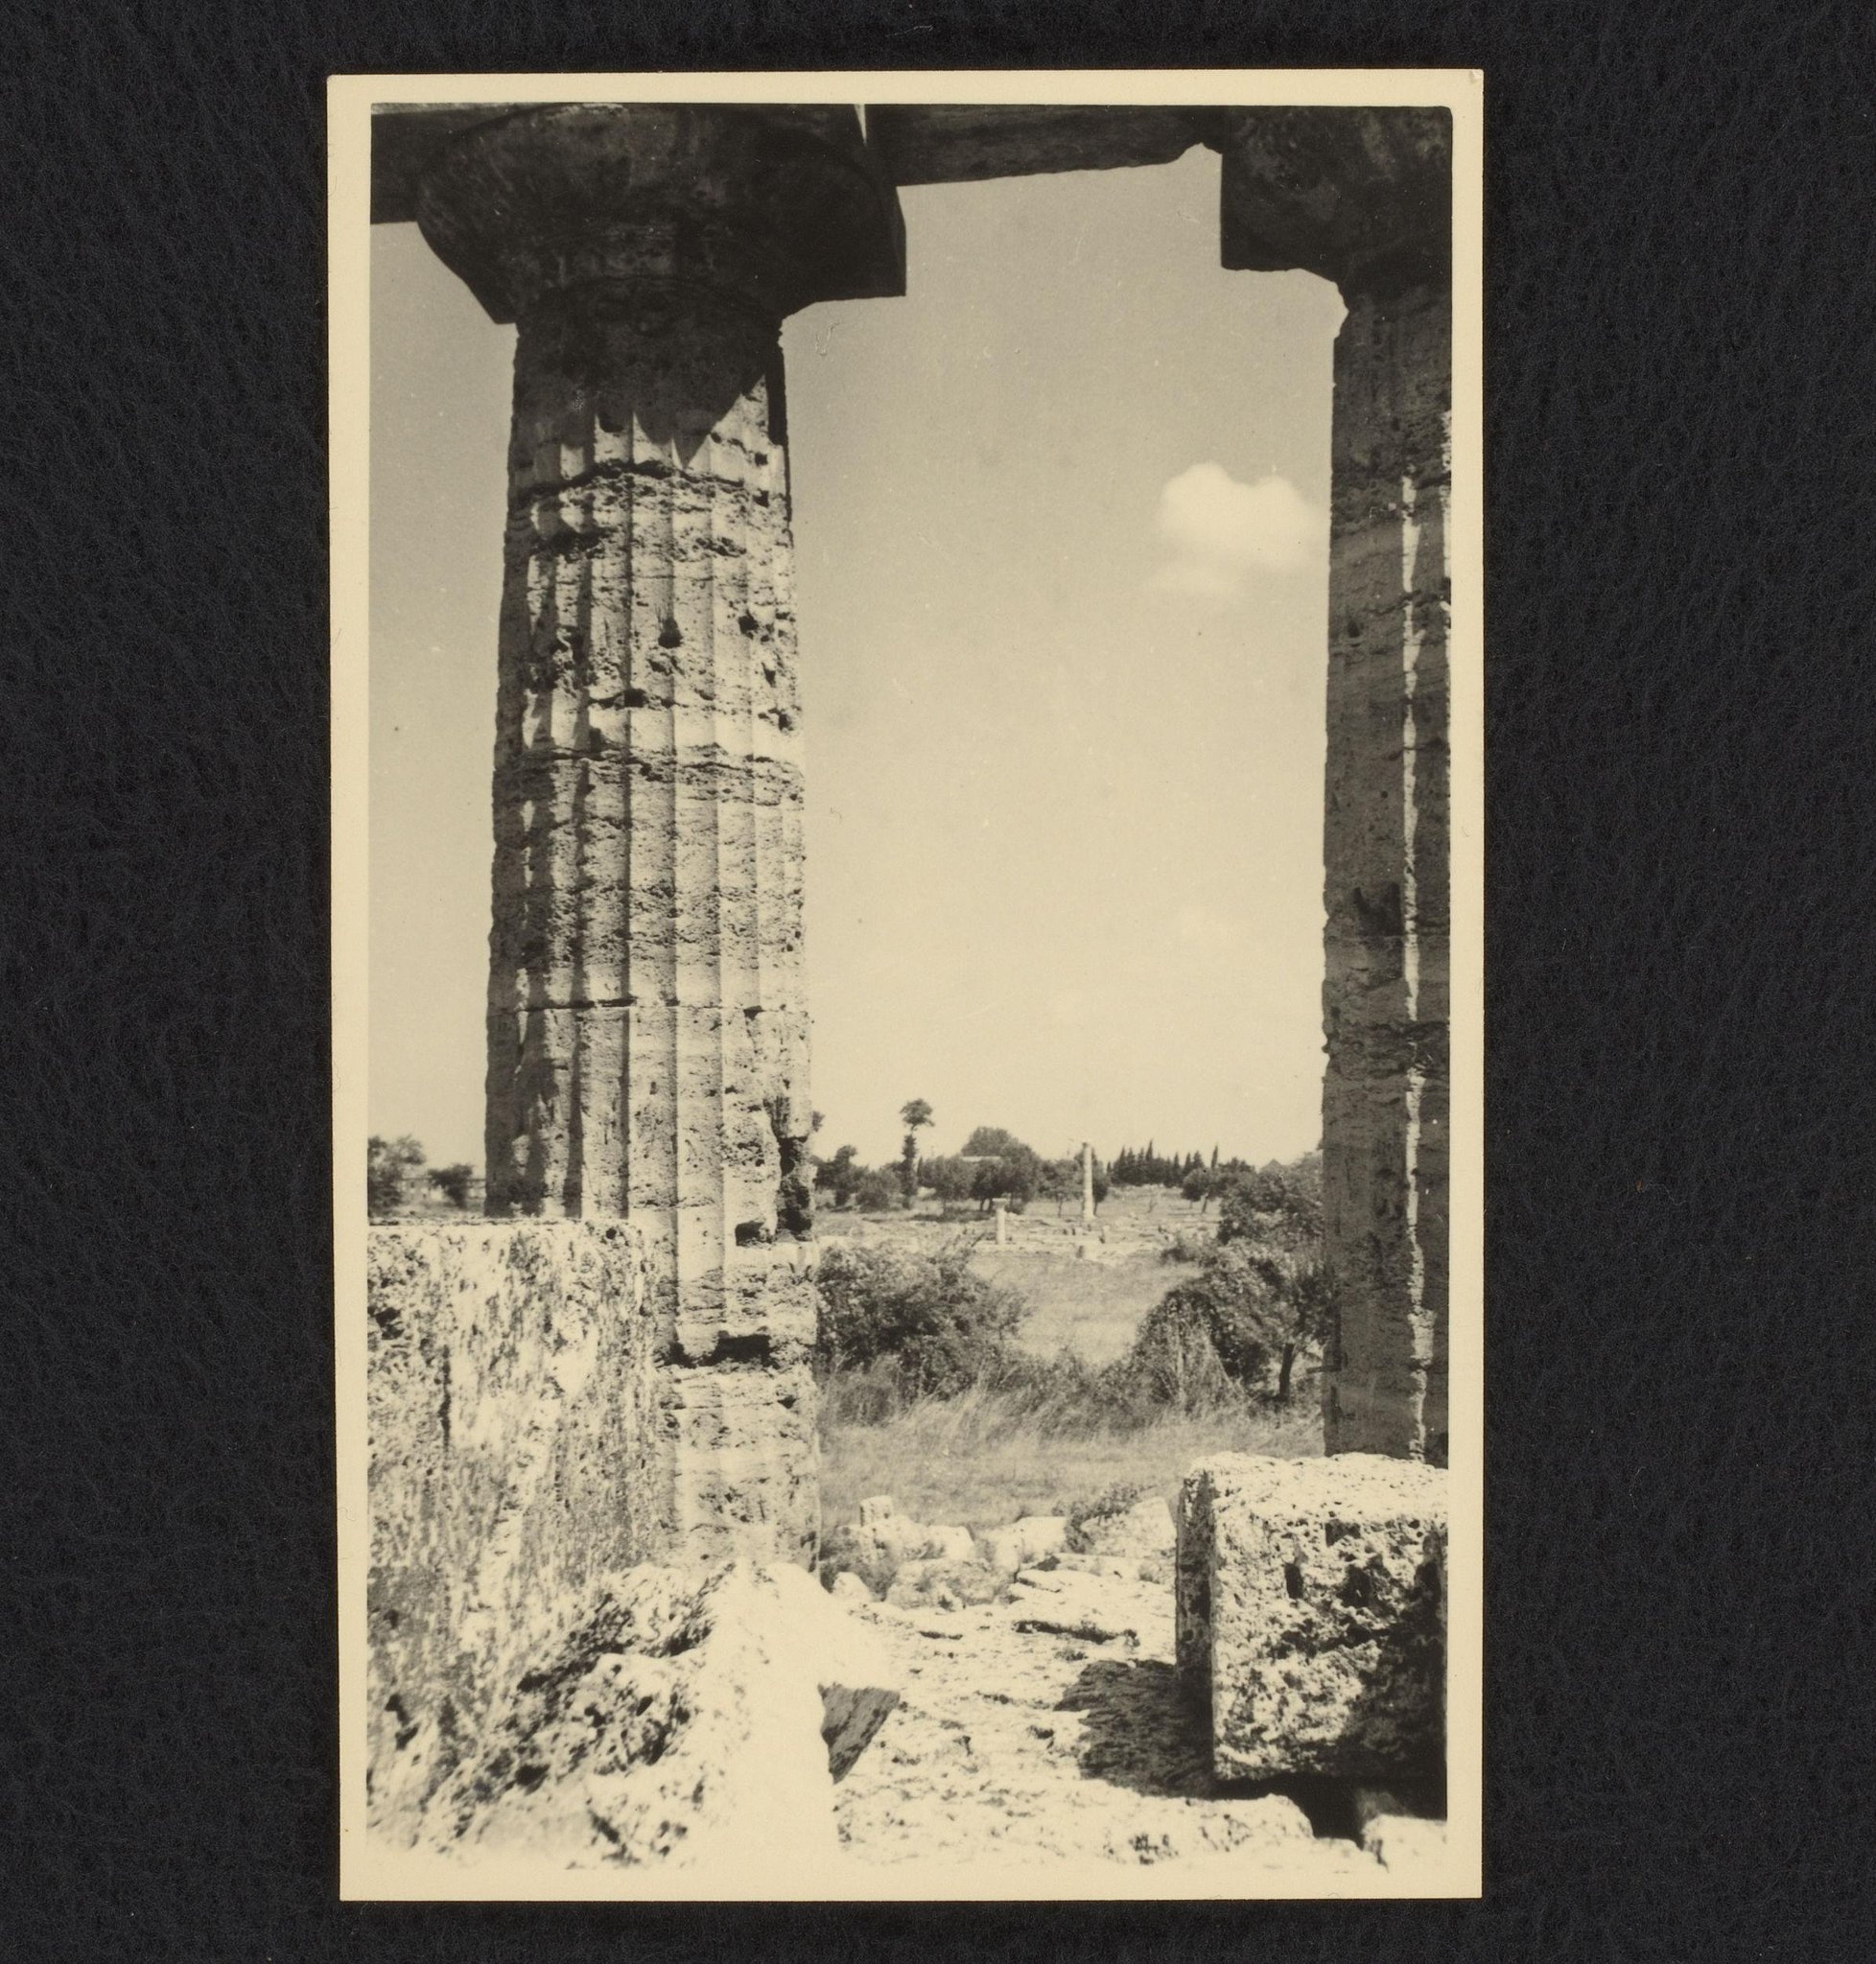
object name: photograph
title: Sorrento - Alberghi visti dal mare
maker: Anonymous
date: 1954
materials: paper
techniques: gelatin silver print, writing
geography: como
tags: rocky coast, villa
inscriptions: poststempel, verso, gestempeld